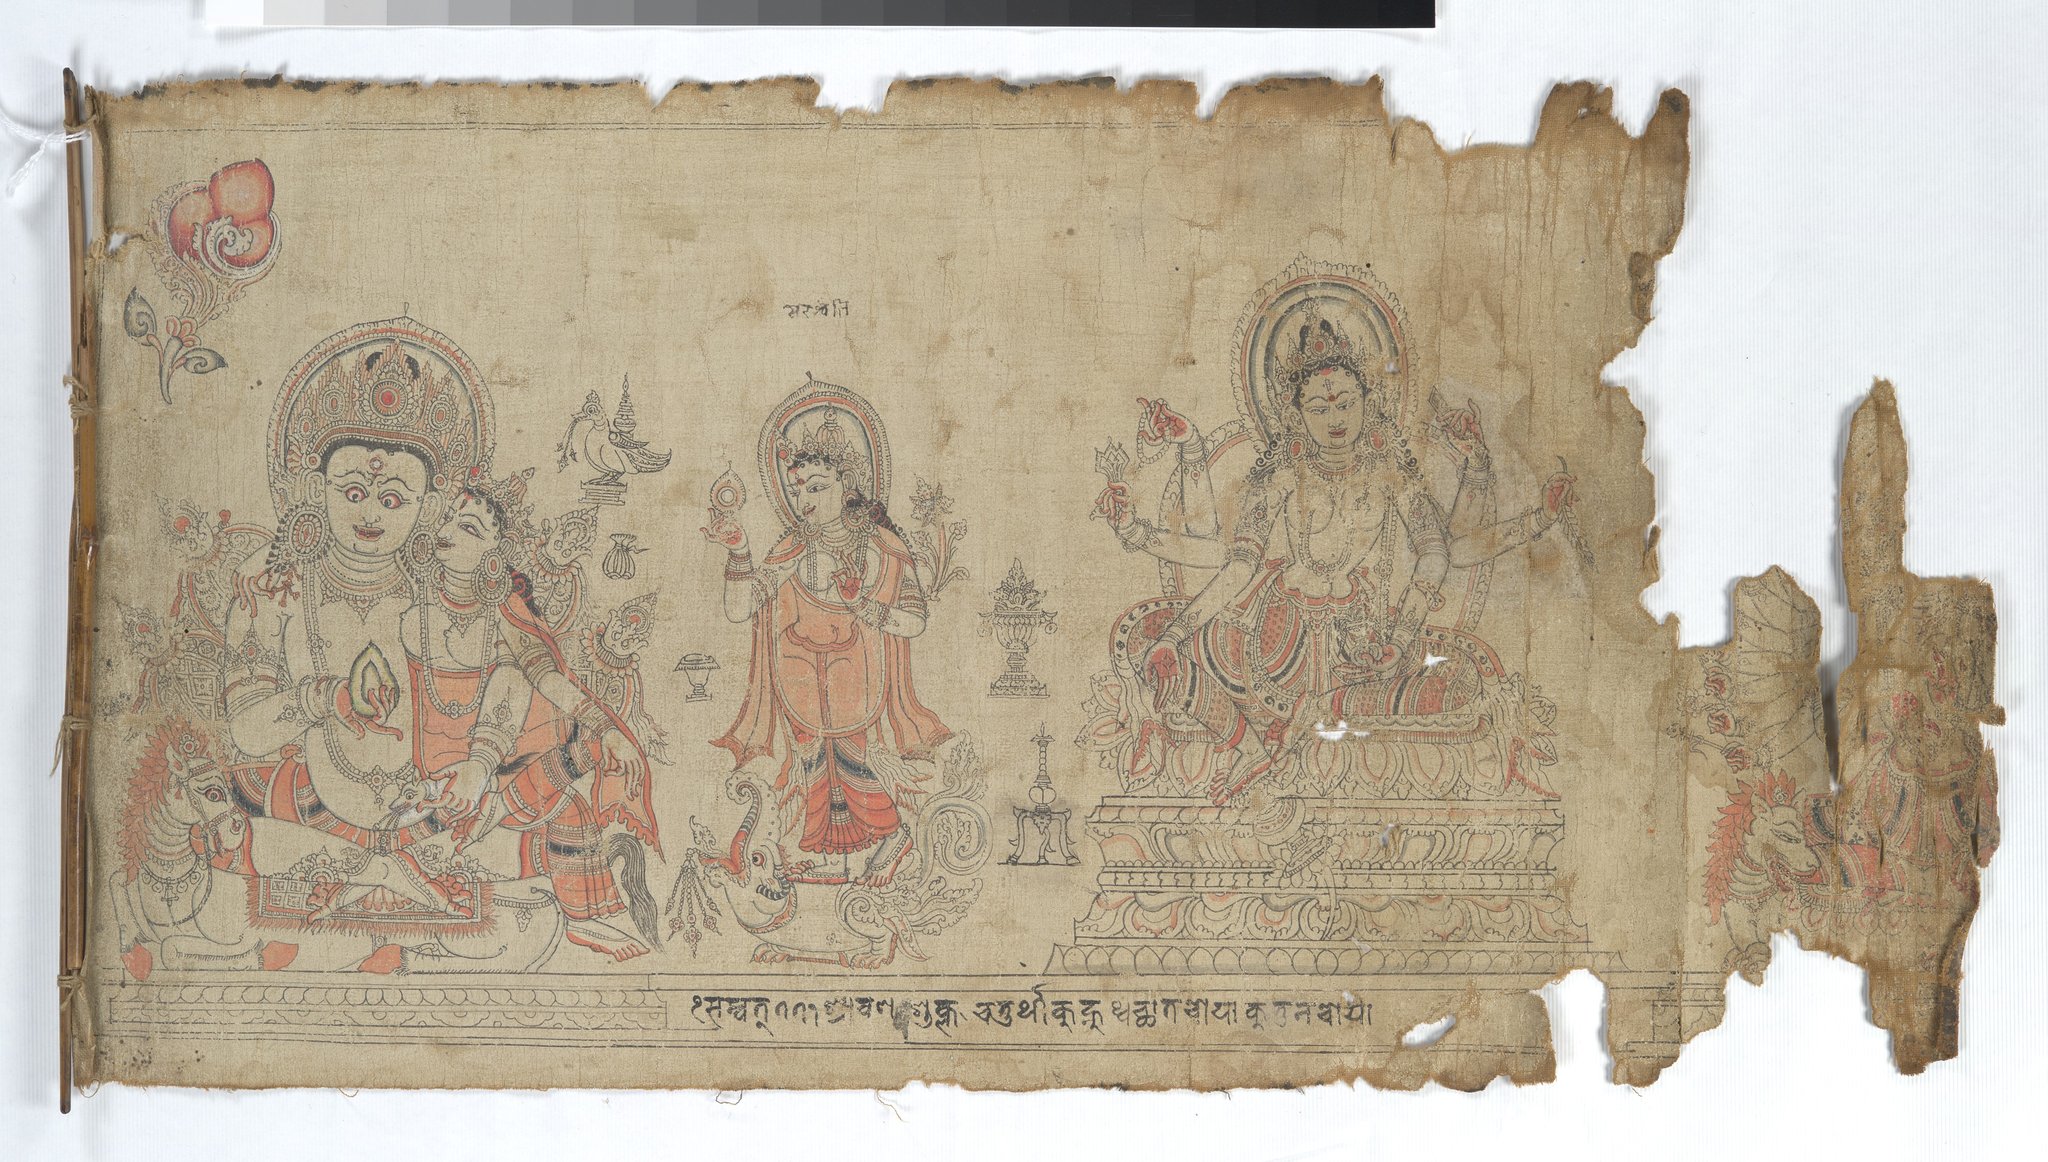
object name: scroll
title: The Goddess Vasudhara Flanked by Kubera and a Fragmentary Durga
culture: nepali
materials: textile, ink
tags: deities,goddess,durga